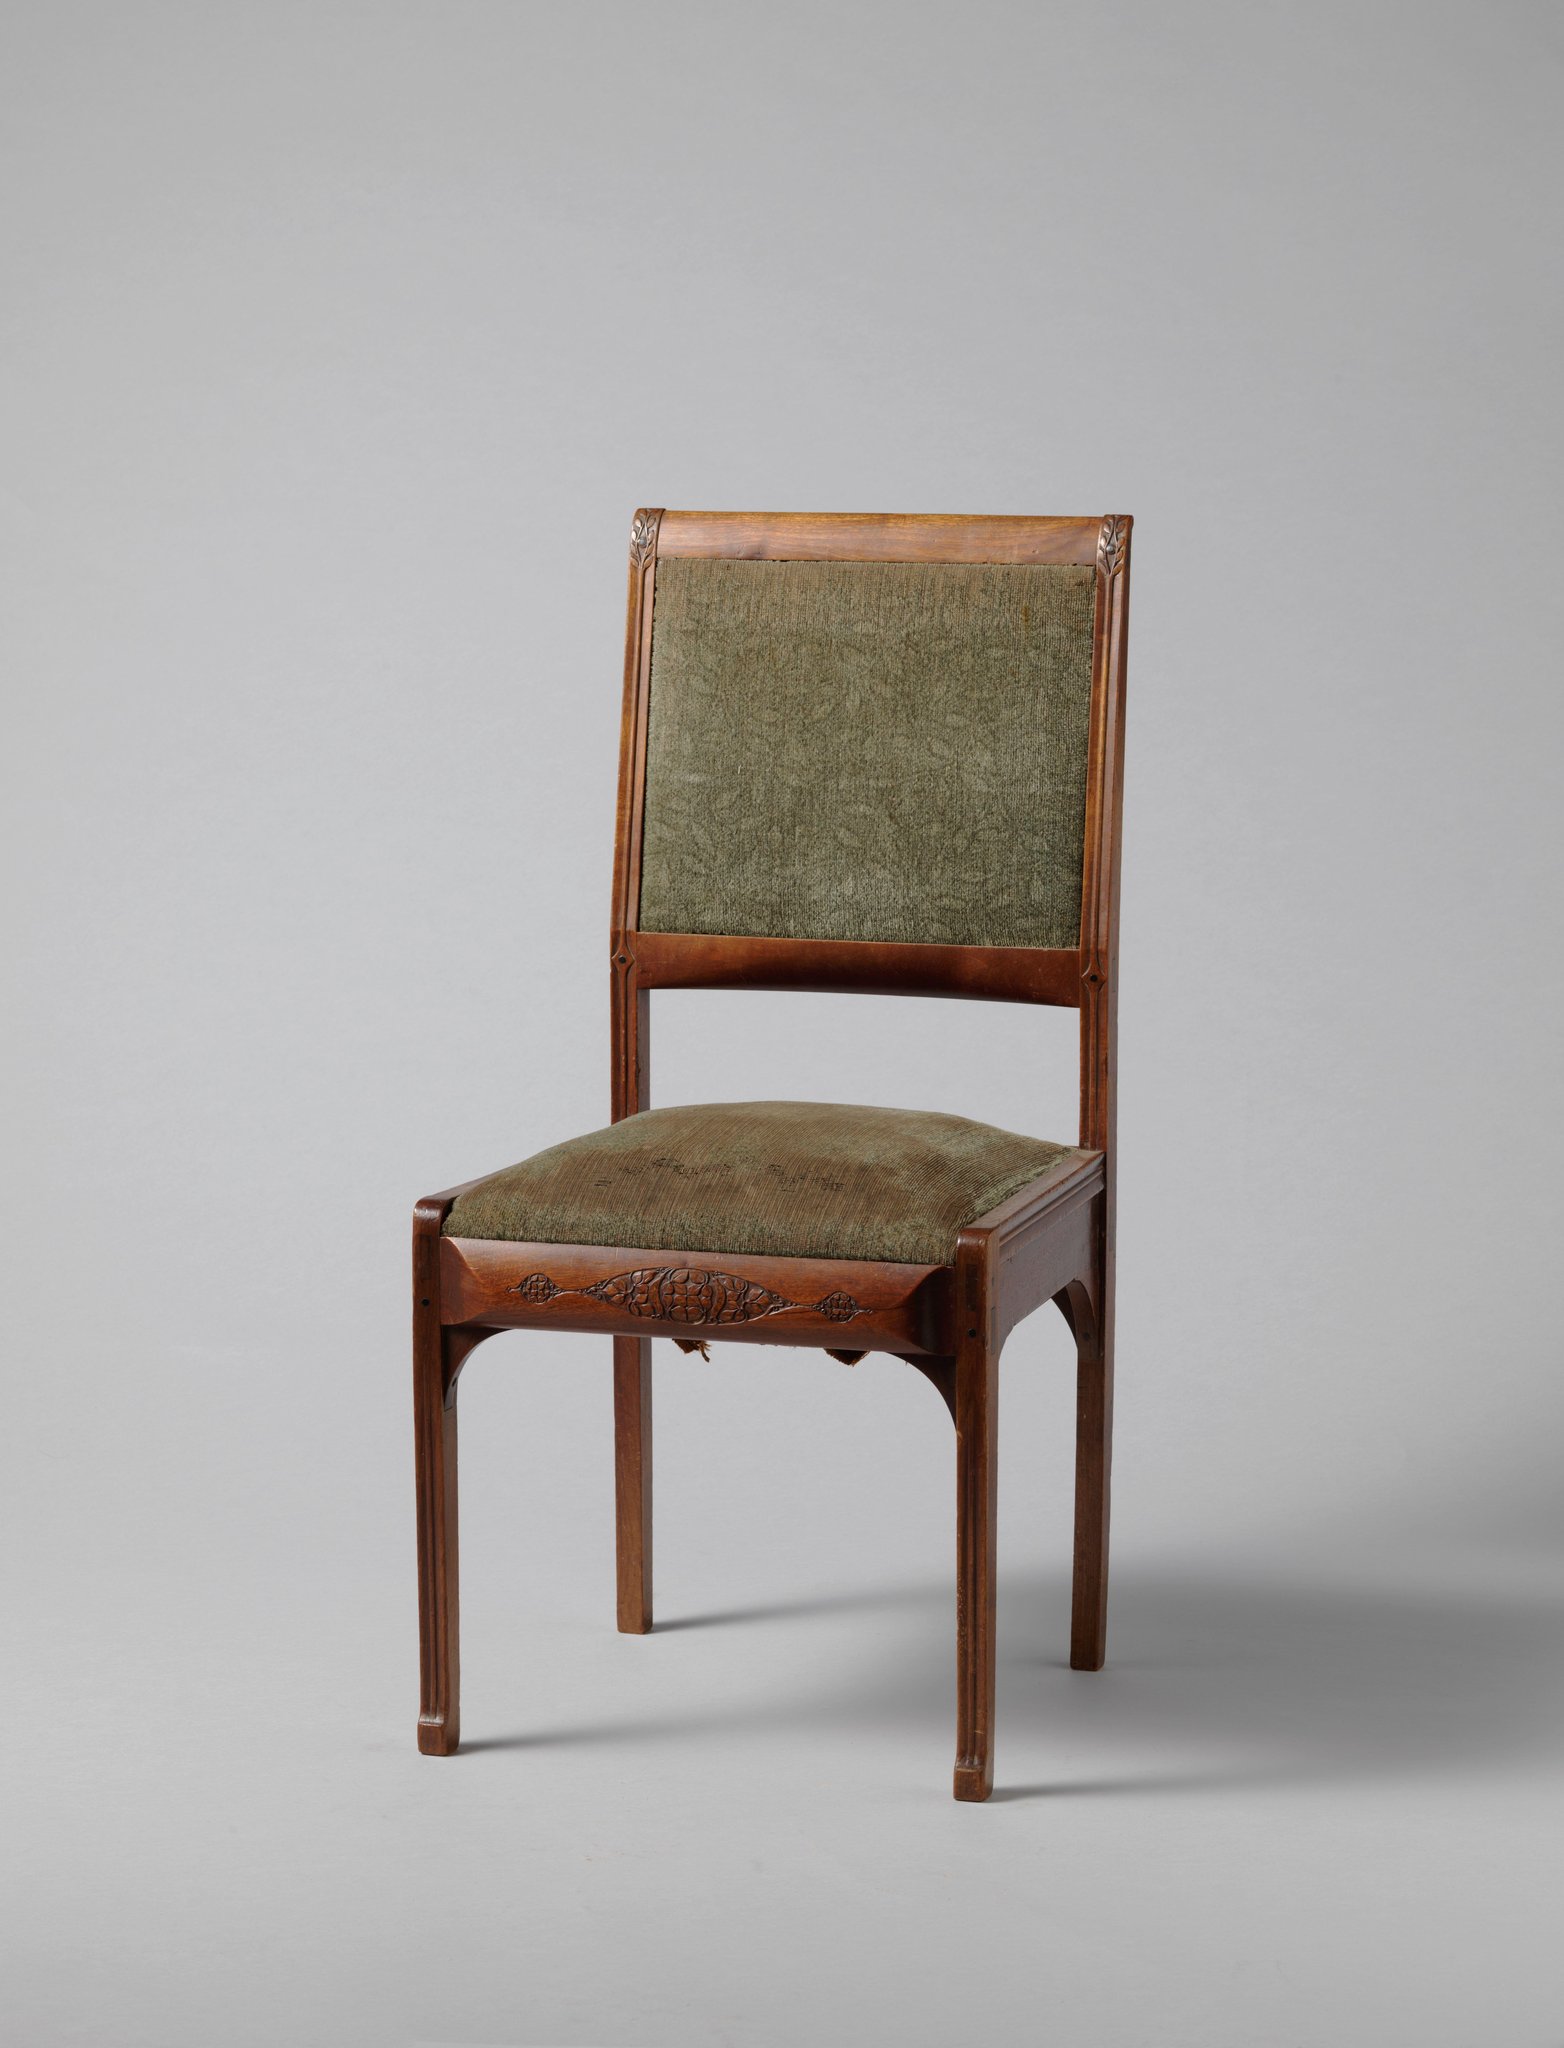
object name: chair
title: Stoel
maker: theo nieuwenhuis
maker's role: designer, draughtsman, print maker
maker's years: 1866-1951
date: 1900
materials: wood, textile, wool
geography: netherlands